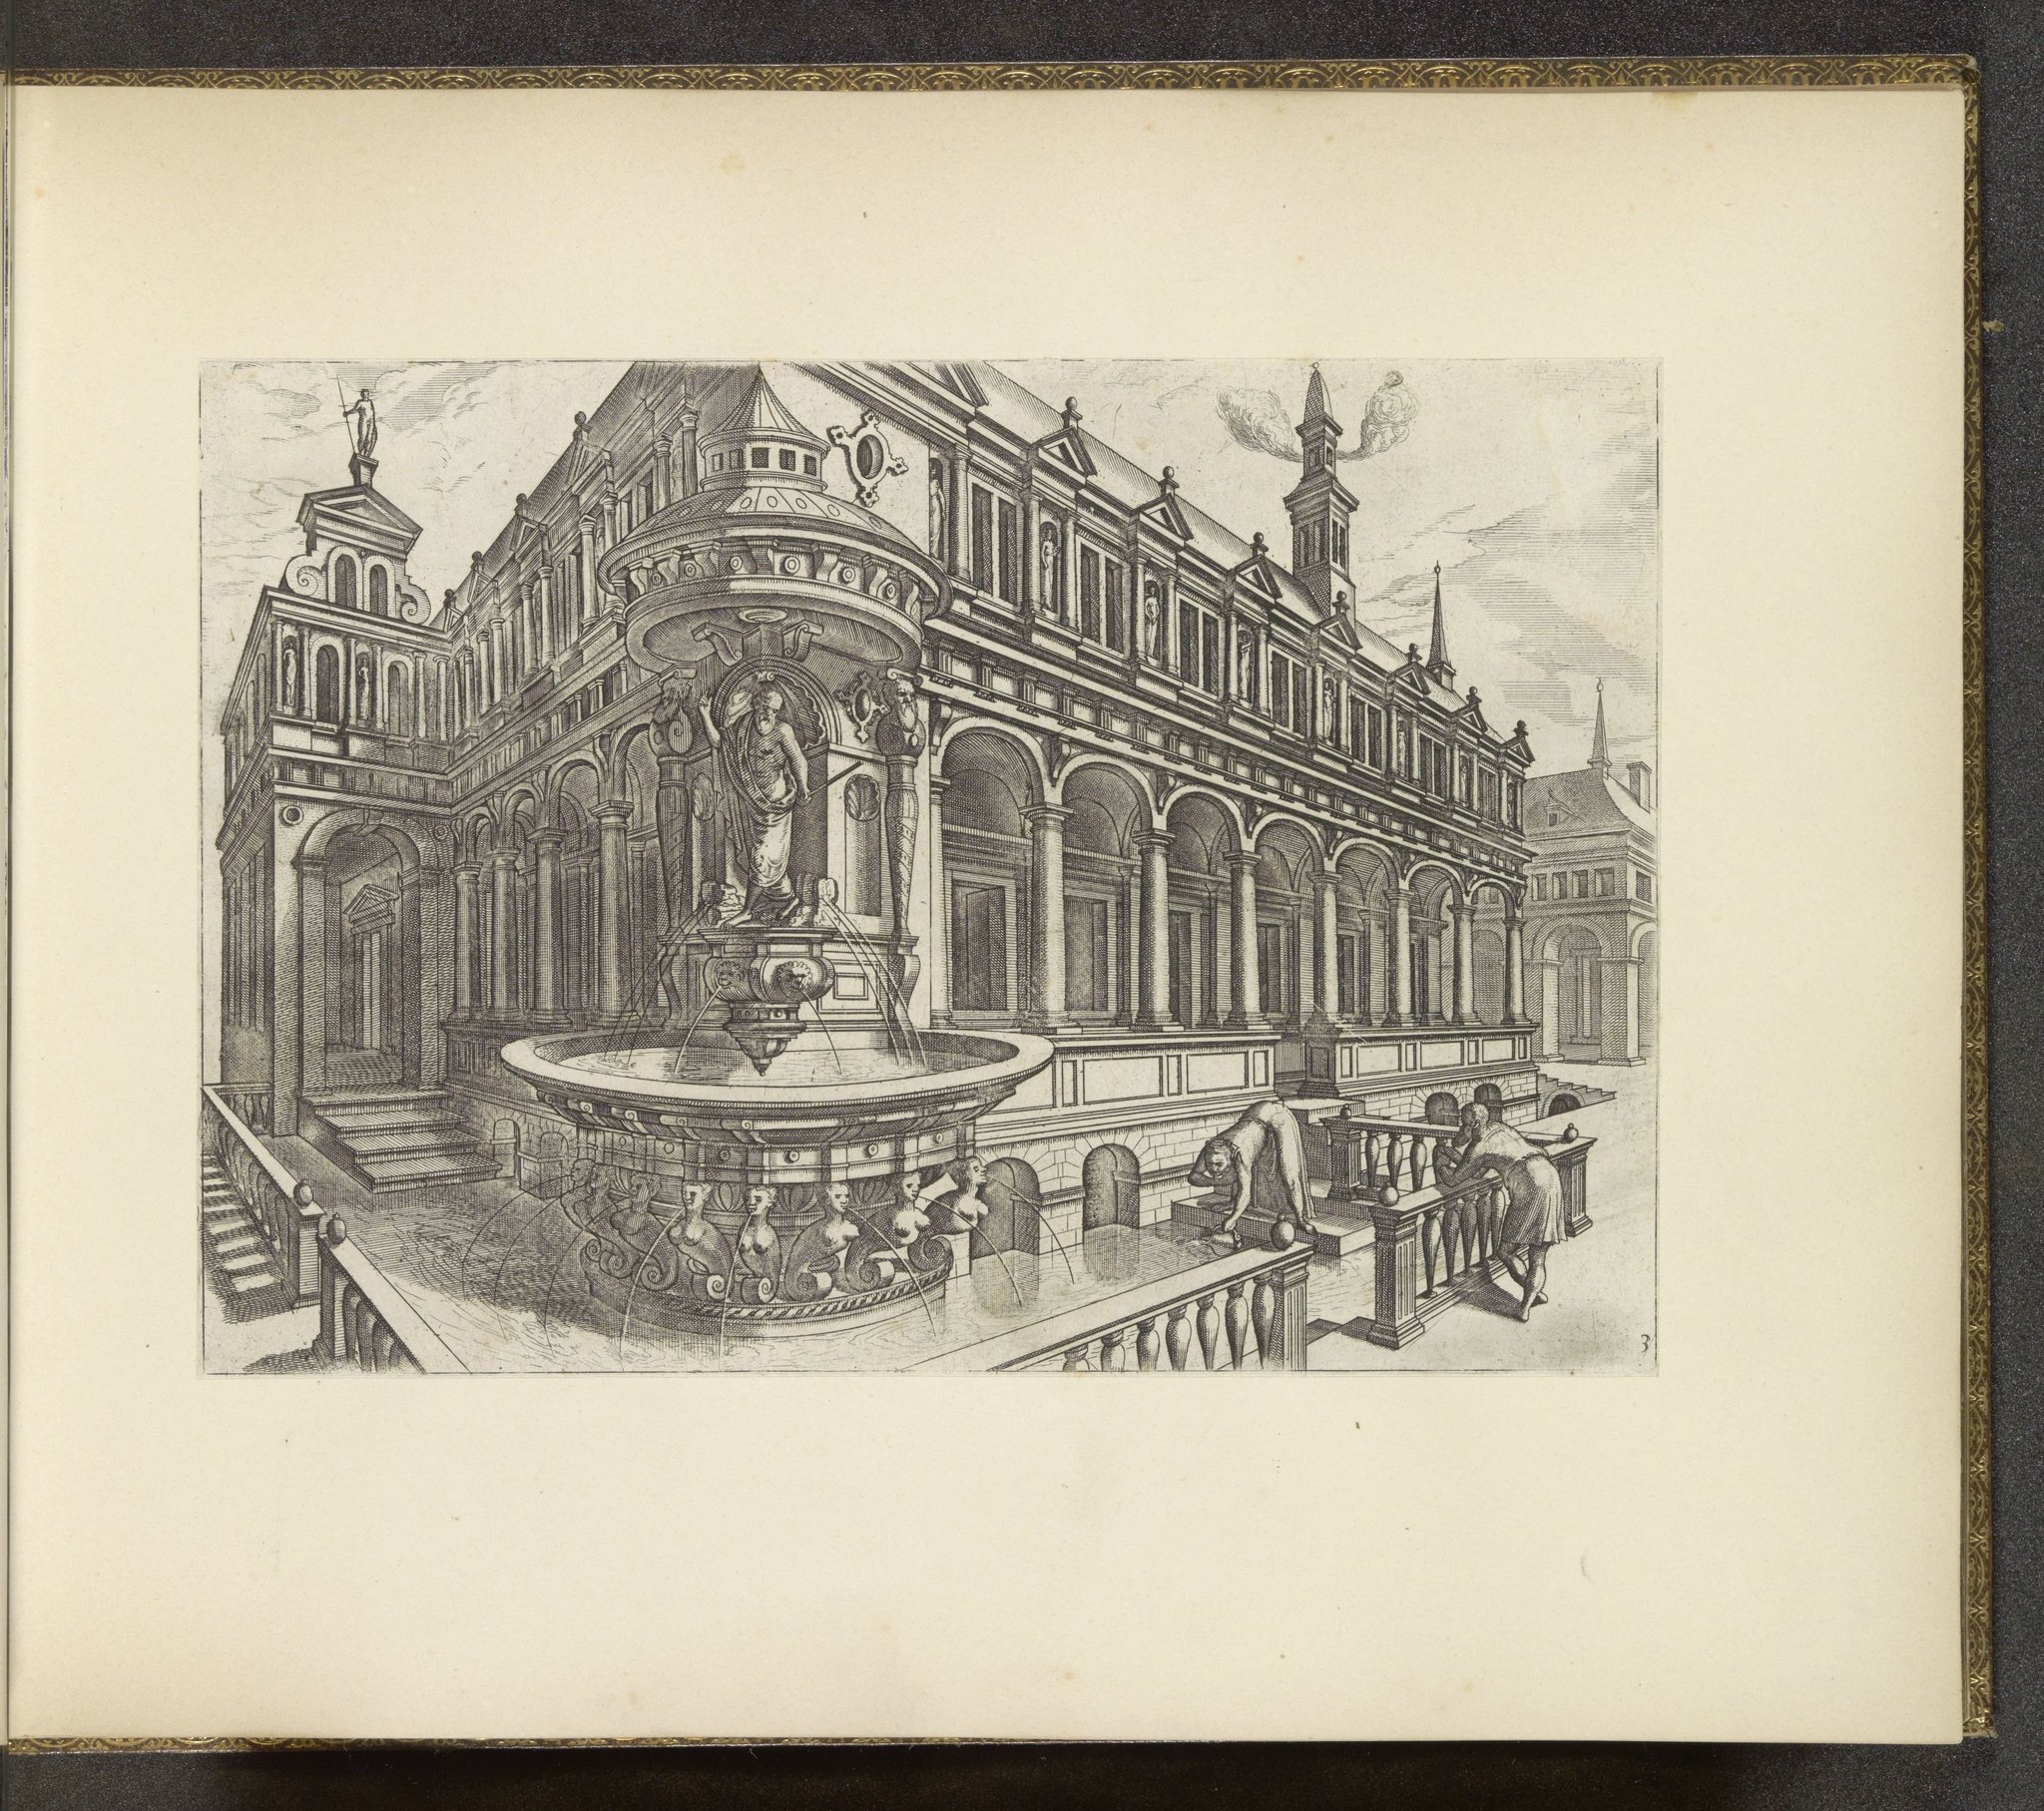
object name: print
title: Fontein met een standbeeld van Mozes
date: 1600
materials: paper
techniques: etching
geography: antwerp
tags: moses (not in biblical context); possible attributes: rays of light or horns on his head, rod, tables of the law, piece of sculpture, reproduction of a piece of sculpture, ornamental fountain, civic architecture; edifices; dwellings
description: Ronde fontein op de hoek van een galerij. Het bekken wordt gedragen door water spuwende sfinxen. Boven het bekken staat op een console Mozes die water uit de rots slaat. Hij staat voor een nis in de hoek van de muur en onder een rond afdak. Rechts leunt een man tegen de balustrade. Een andere man schept met een kan water uit de fontein. De prent maakt deel uit van een album.